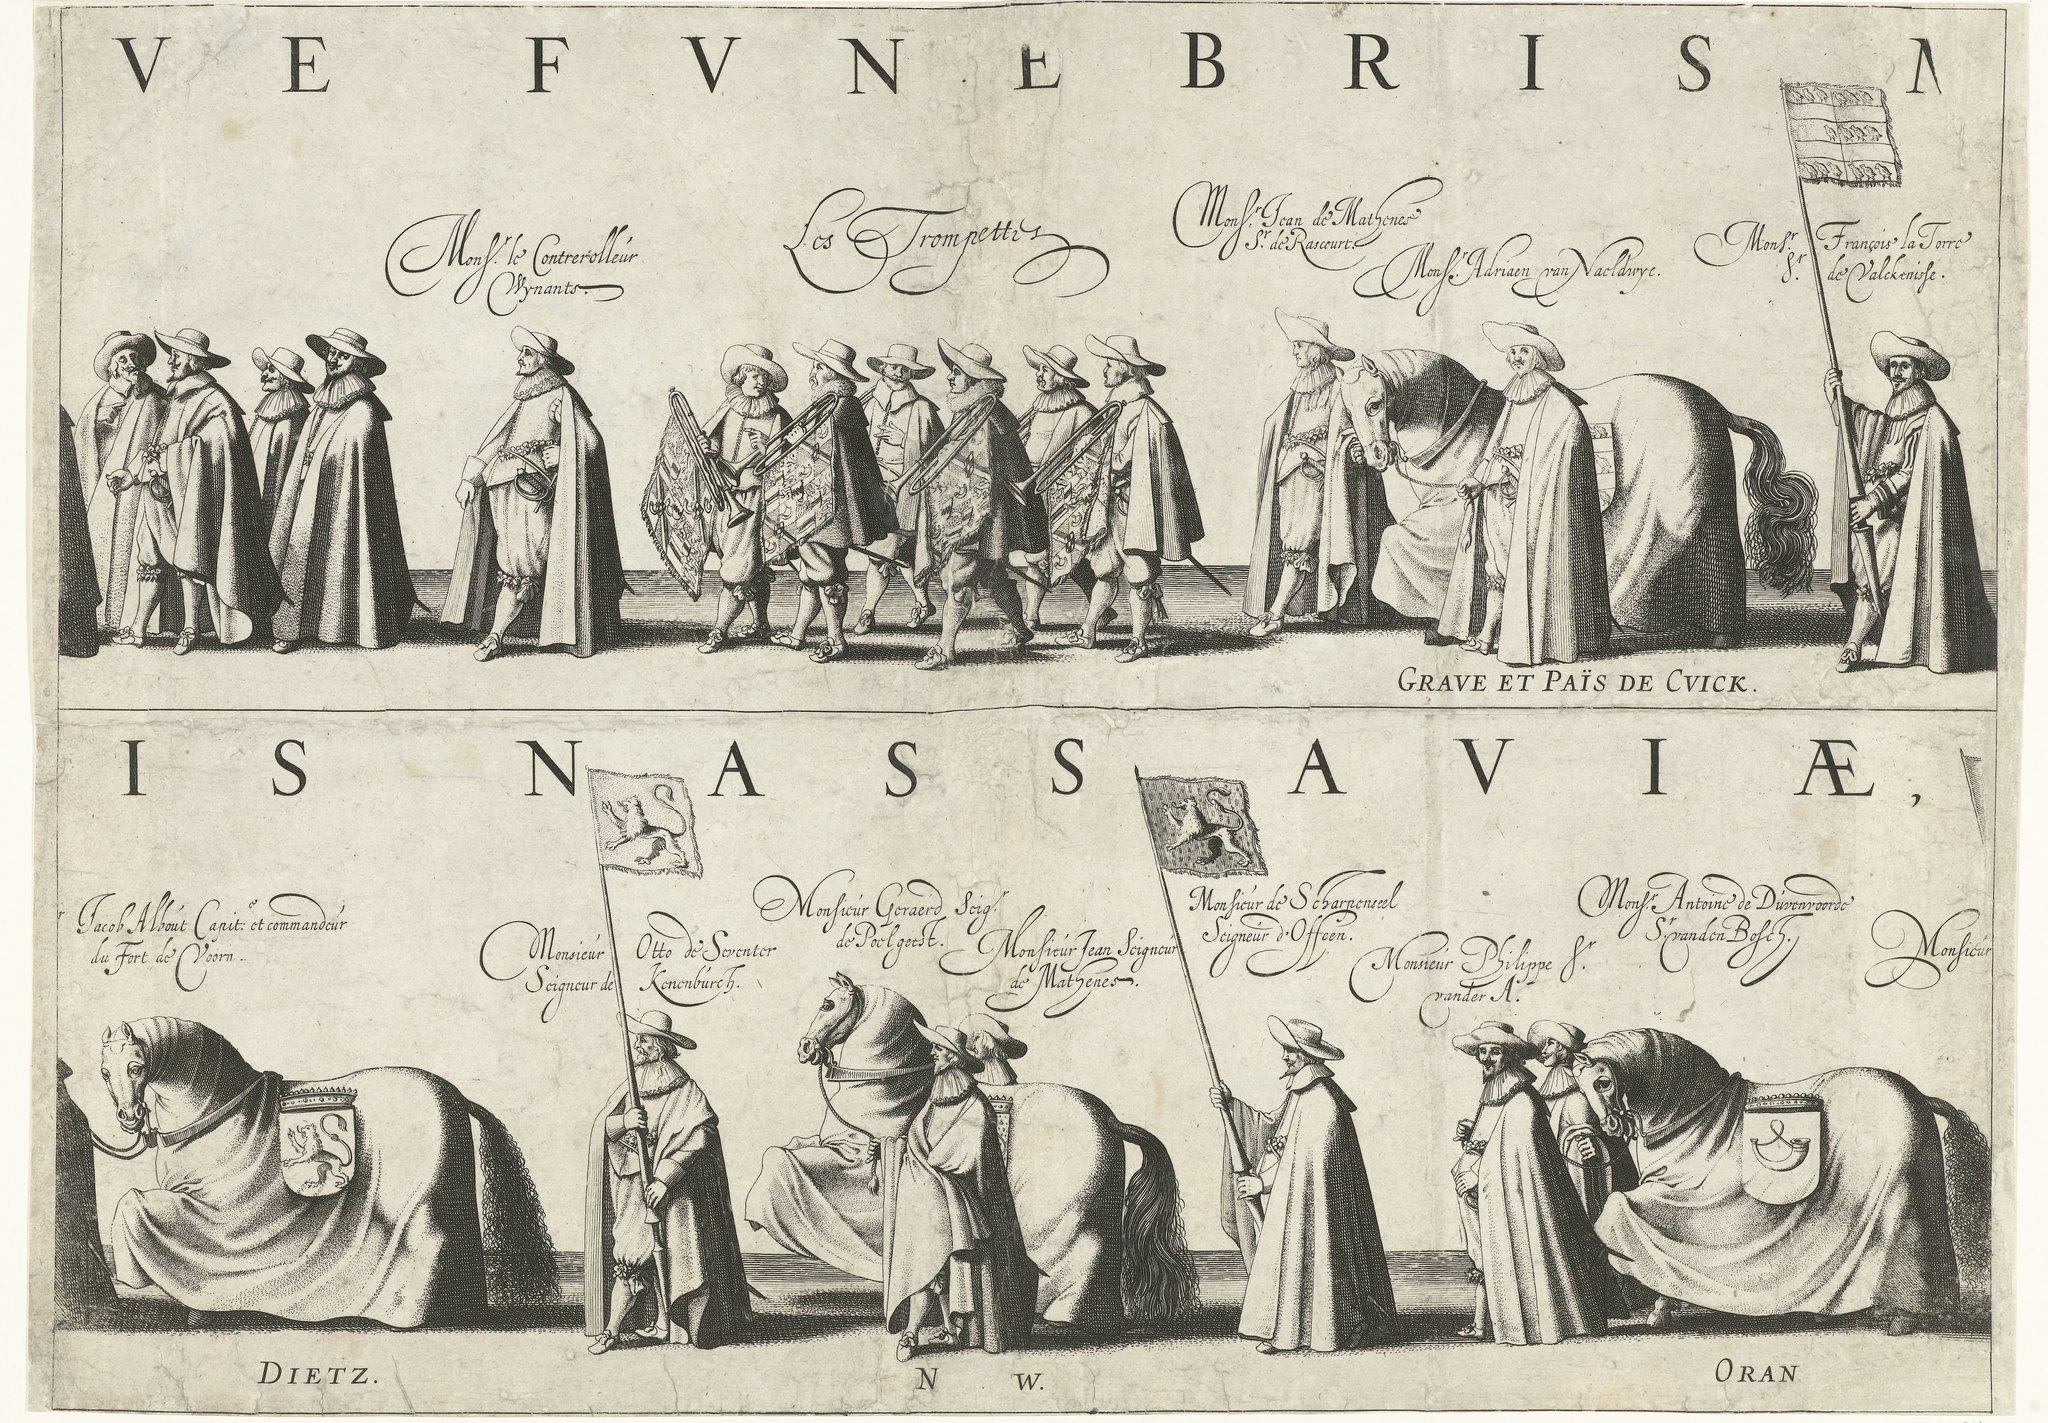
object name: print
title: De begrafenisstoet van prins Maurits te Delft, 1625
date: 1626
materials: paper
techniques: etching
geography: northern netherlands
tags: the hague, maurice (prince of orange), cortege, funeral procession, delft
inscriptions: date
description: De begrafenisstoet van prins Maurits te Delft op 16 september 1625 (plaat 3). Plaat verdeeld in twee voorstellingen. Boven: deel van de stoet met deelnemers, muzikanten en een paard. Onder: deel van de stoet met deelnemers en 3 paarden. Met de namen van de afgebeelde personen.